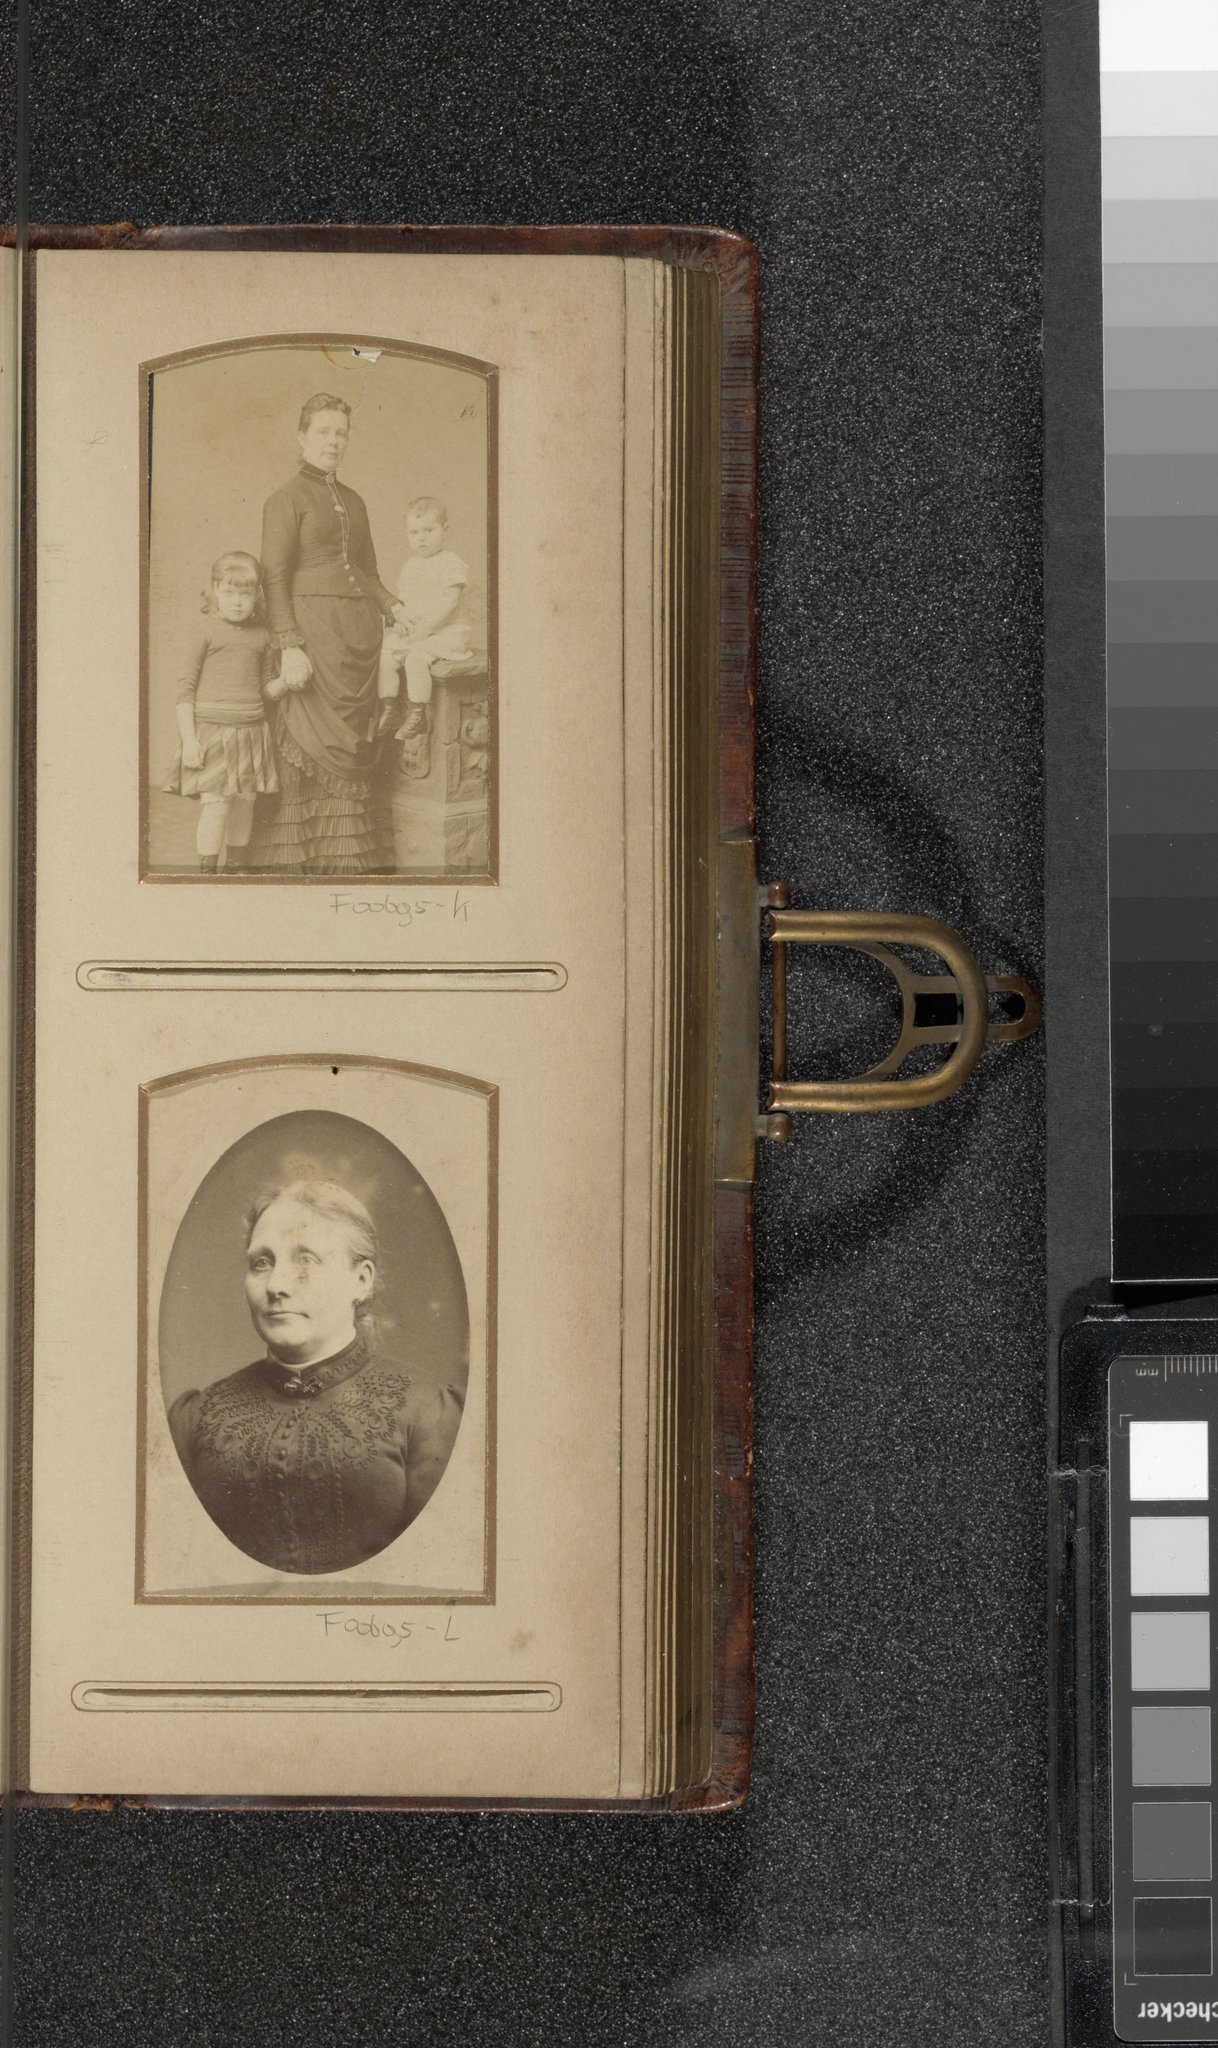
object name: carte de visite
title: Portret van een vrouw met twee kinderen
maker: marius n.f. rotteveel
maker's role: fotograaf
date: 1878-1892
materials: cardboard, paper, photographic support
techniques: albumen print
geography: haarlem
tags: studio requisites ~ photographer, mother and baby or young child, haarlem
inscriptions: address: ‘Jansweg 13 Haarlem’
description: Onderdeel van Album met 28 foto's van een Nederlands-Surinaamse familie.